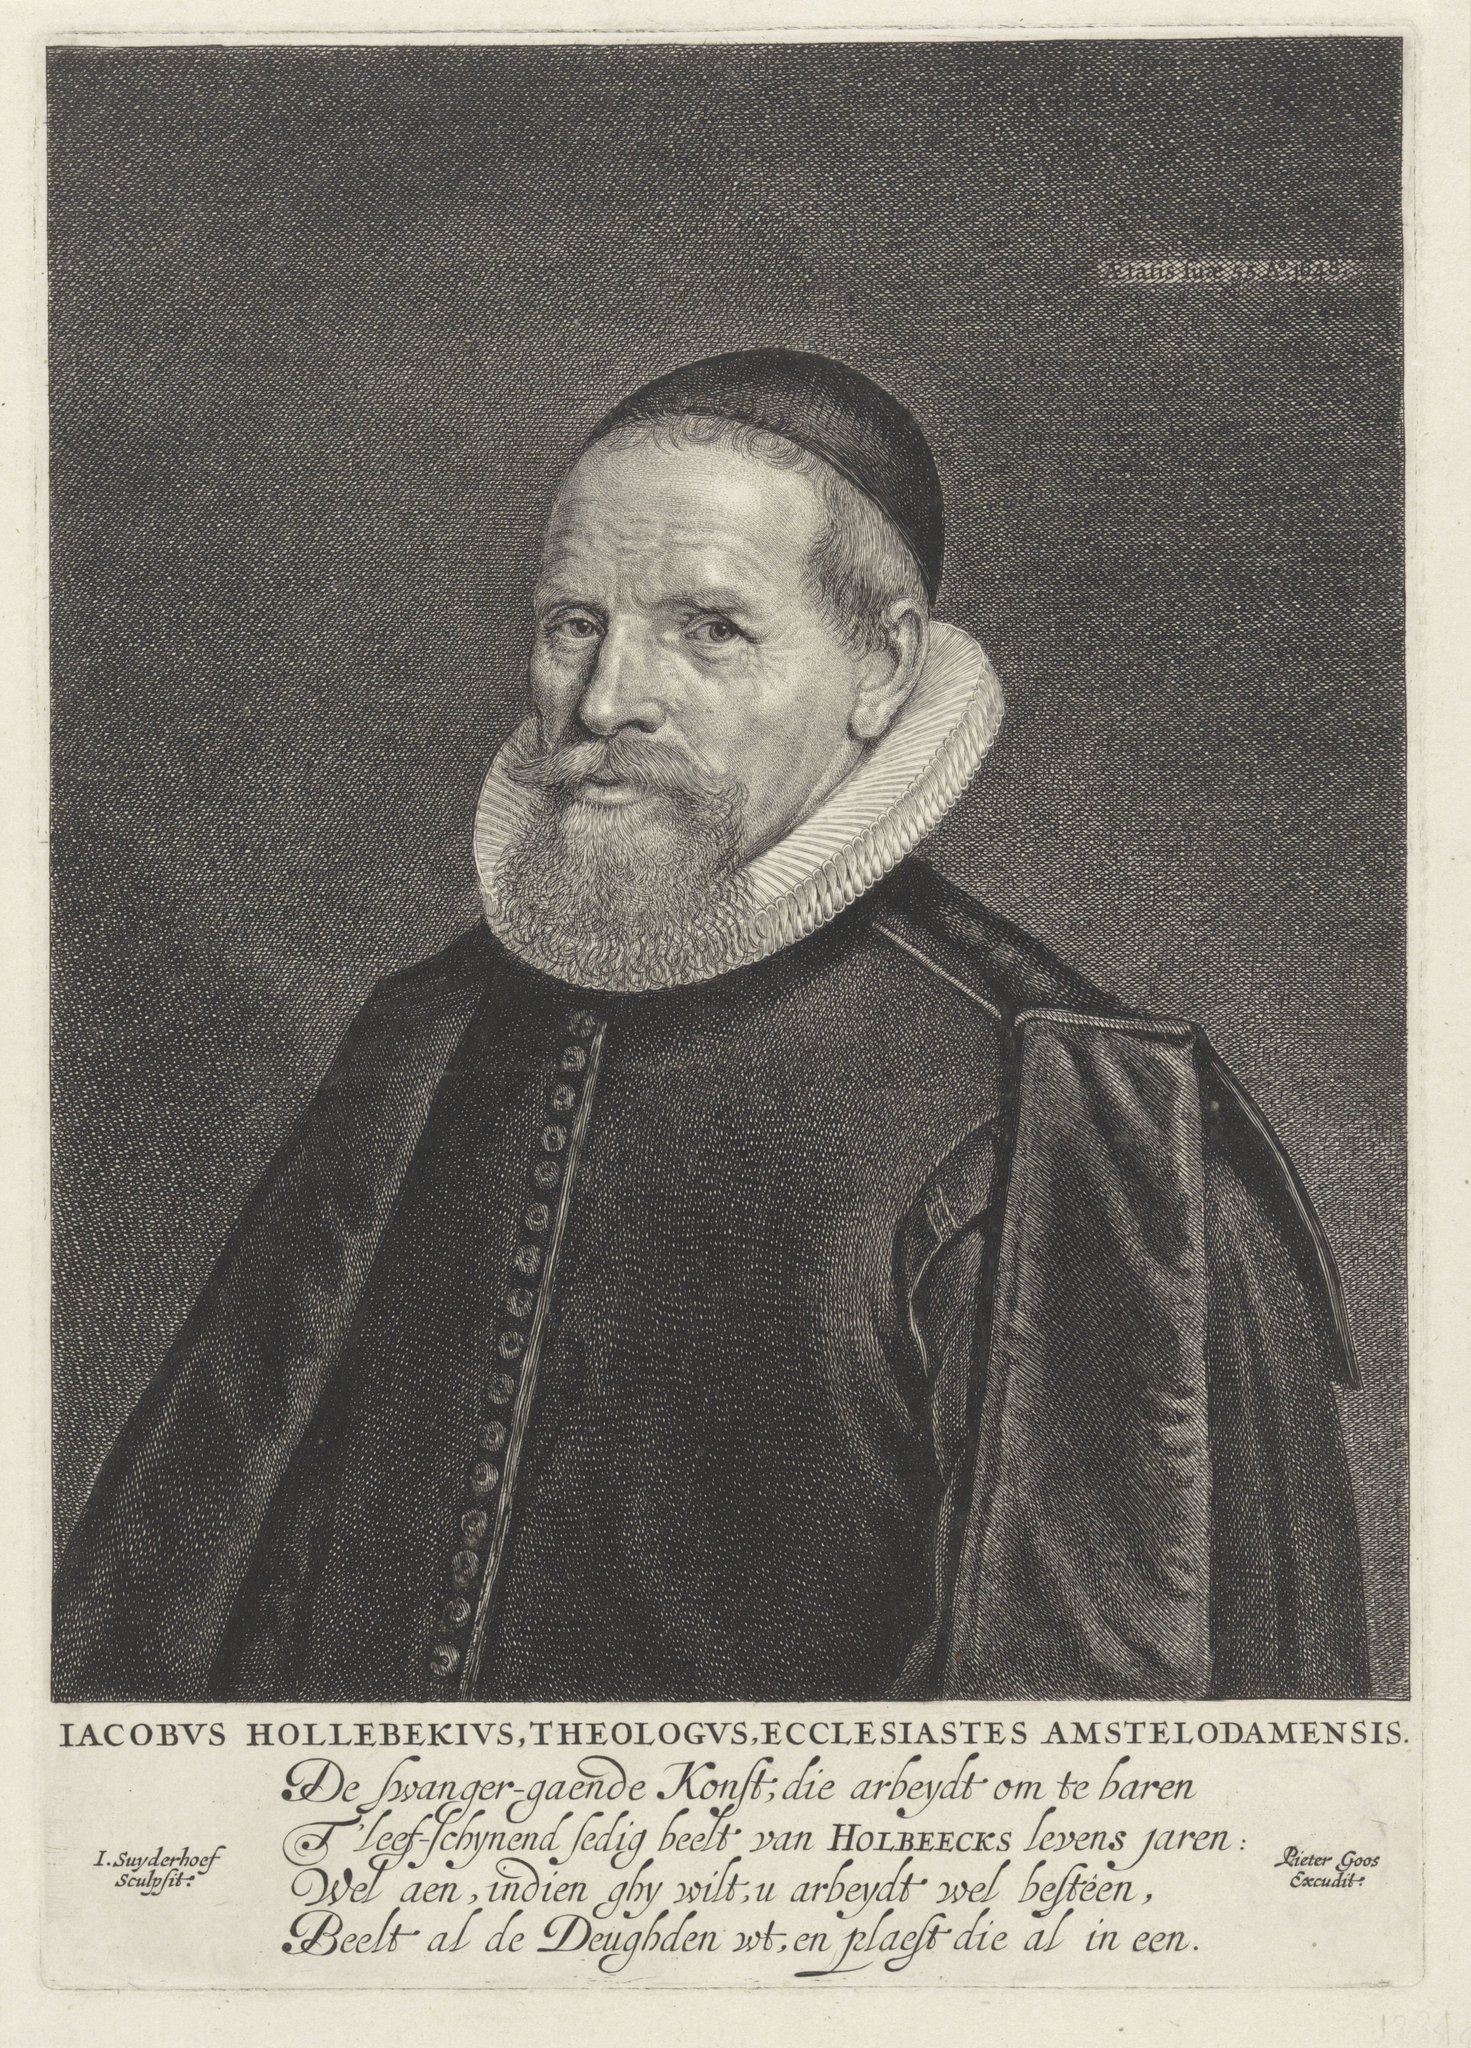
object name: print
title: Portret van Jacobus Hollebeek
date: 1648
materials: paper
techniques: engraving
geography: haarlem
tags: amsterdam, functionaries and dignitaries ~ protestant churches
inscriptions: collector's mark: Lugt 240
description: Portret van Jacobus Hollebeek, predikant te Amsterdam op 55-jarige leeftijd. Onderaan in de marge zijn naam en functie in het Latijn en een vierregelig vers in het Nederlands.